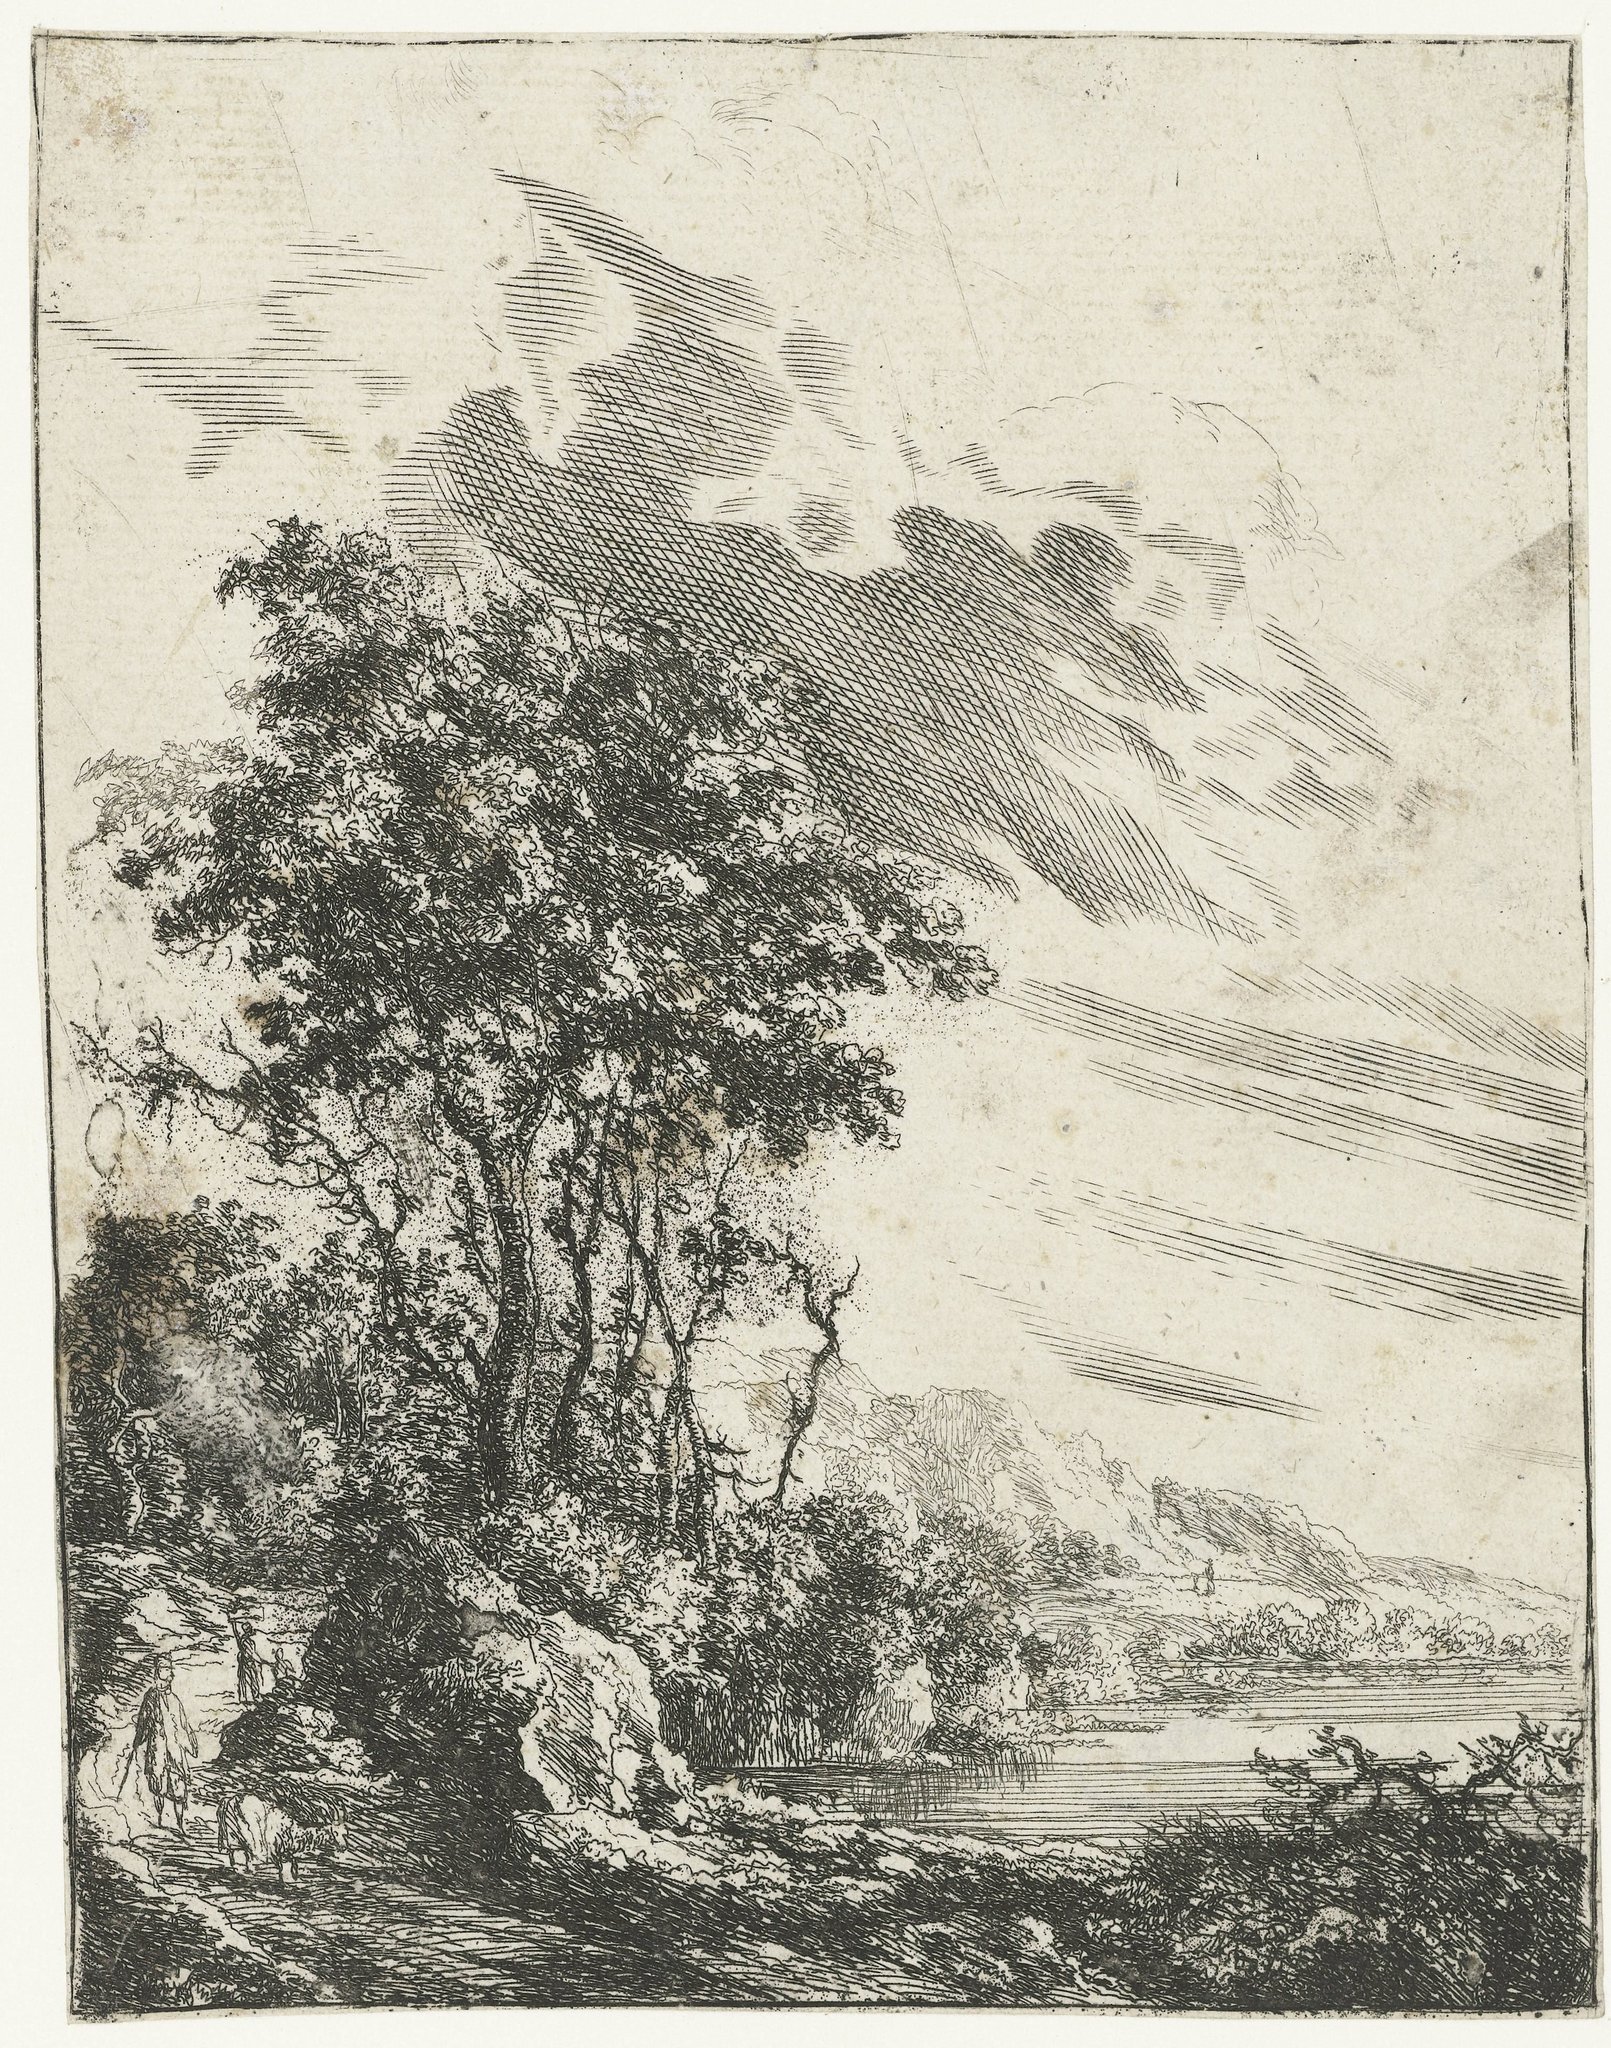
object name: print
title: Rivierlandschap met een man en een geit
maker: gilles neyts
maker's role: draughtsman, print maker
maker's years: 1623-1687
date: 1643-1681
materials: paper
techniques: engraving, etching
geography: antwerp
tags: river, herding, herdsman, herdswoman, shepherd, shepherdess, cowherd, etc., landscapes in the temperate zone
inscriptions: collector's mark: Lugt 2228a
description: Bergachtig landschap. Over een weg langs een rivier drijft een man een geit voort.